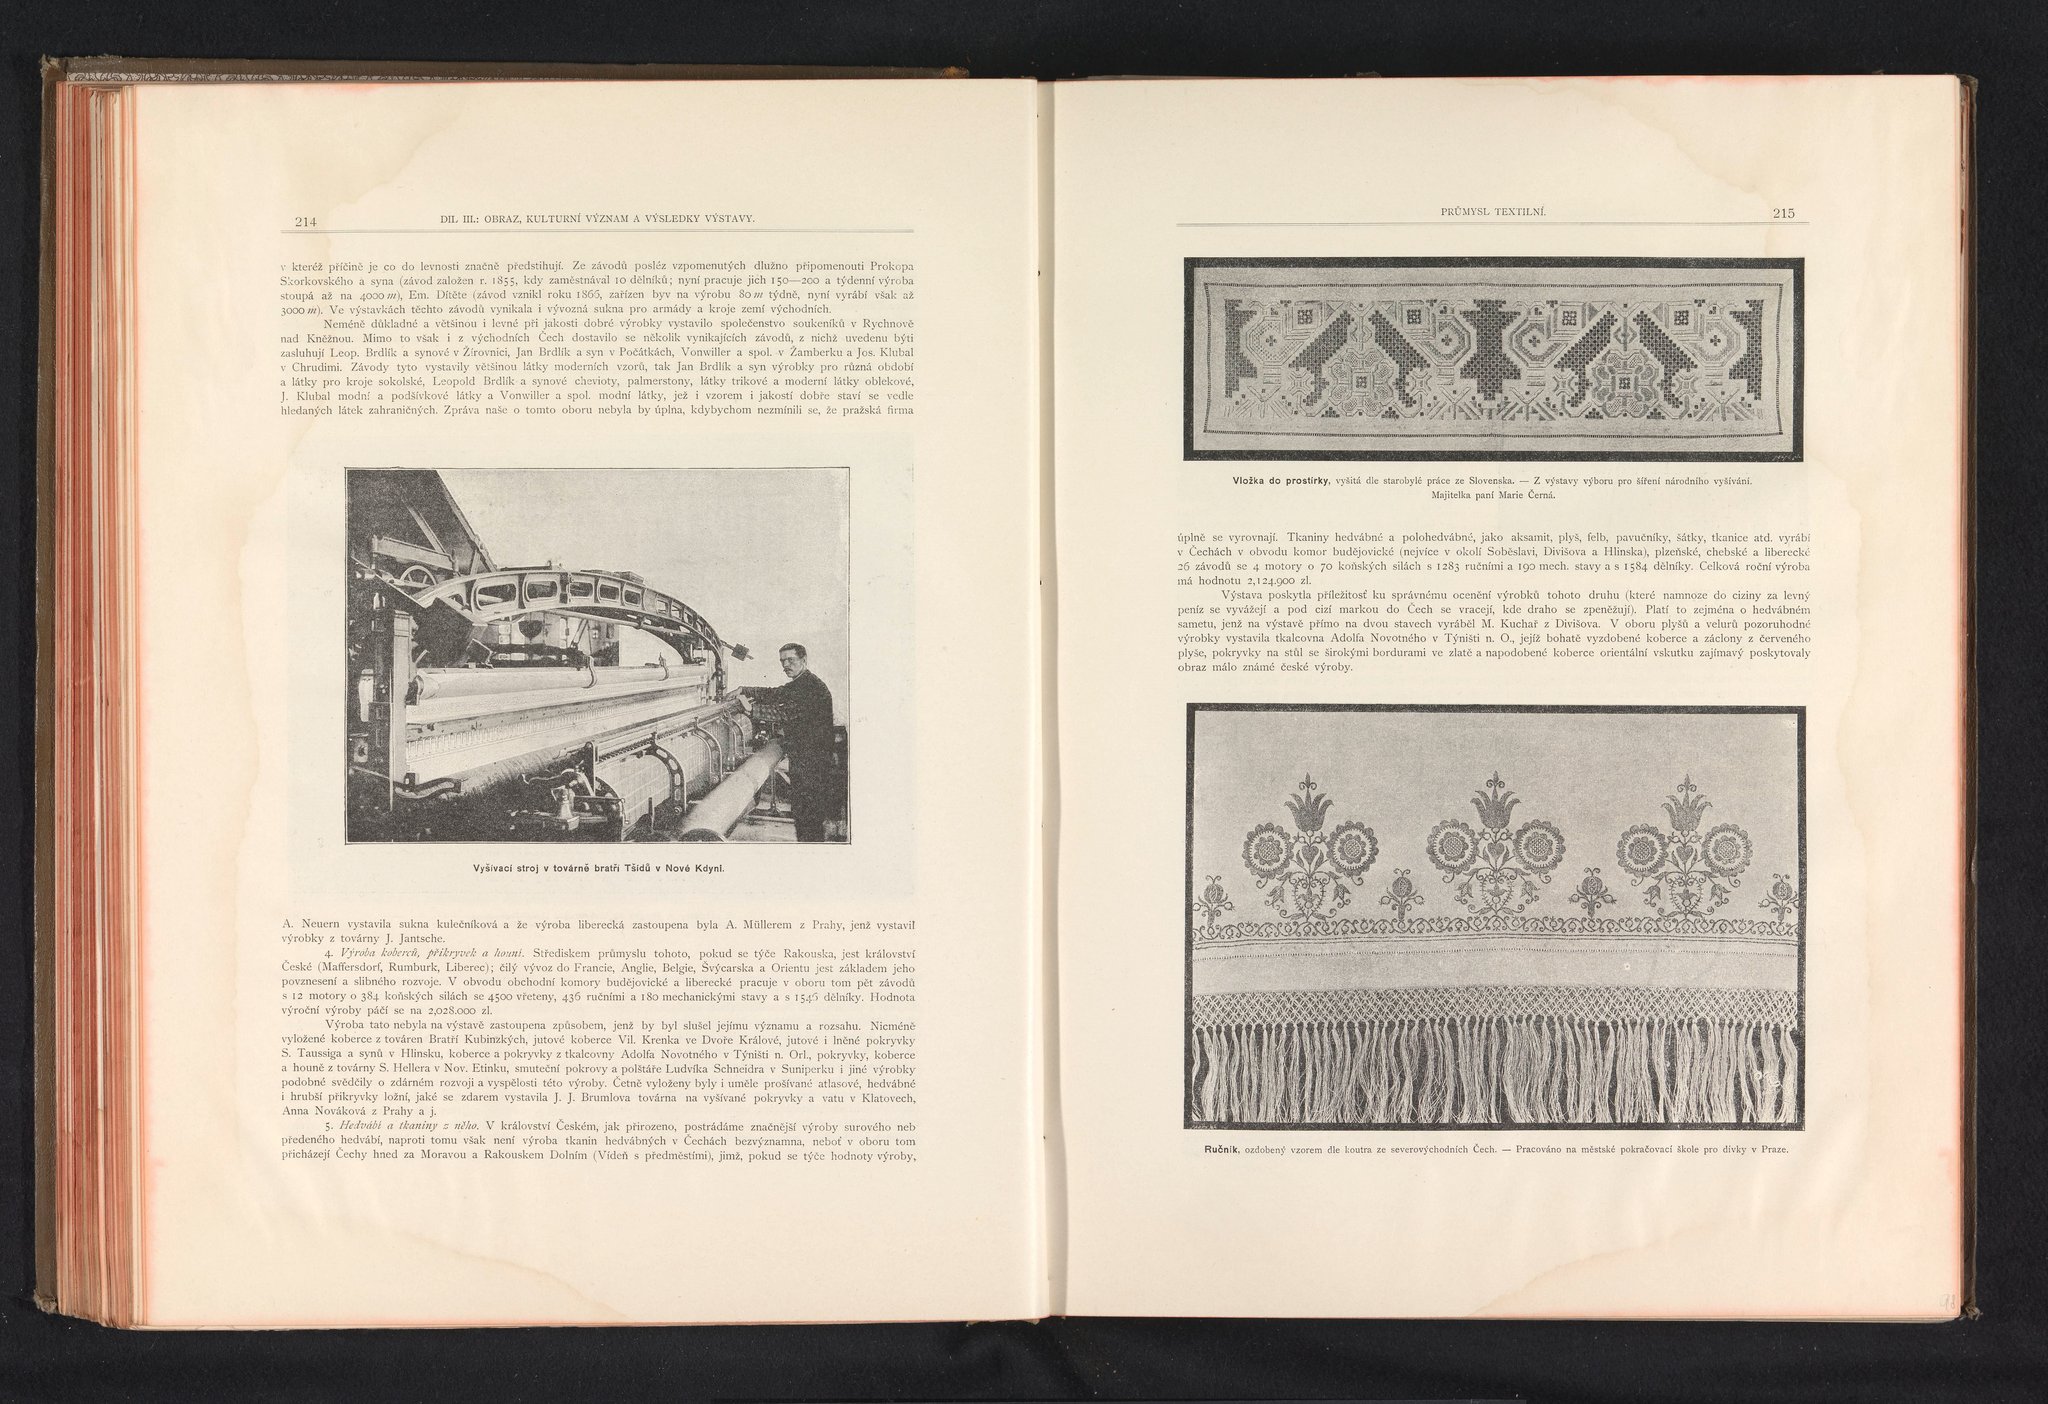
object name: page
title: Rucnik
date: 1890-1895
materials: paper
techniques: autotype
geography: prague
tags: embroidering ~ textile industry, table-ware, towel